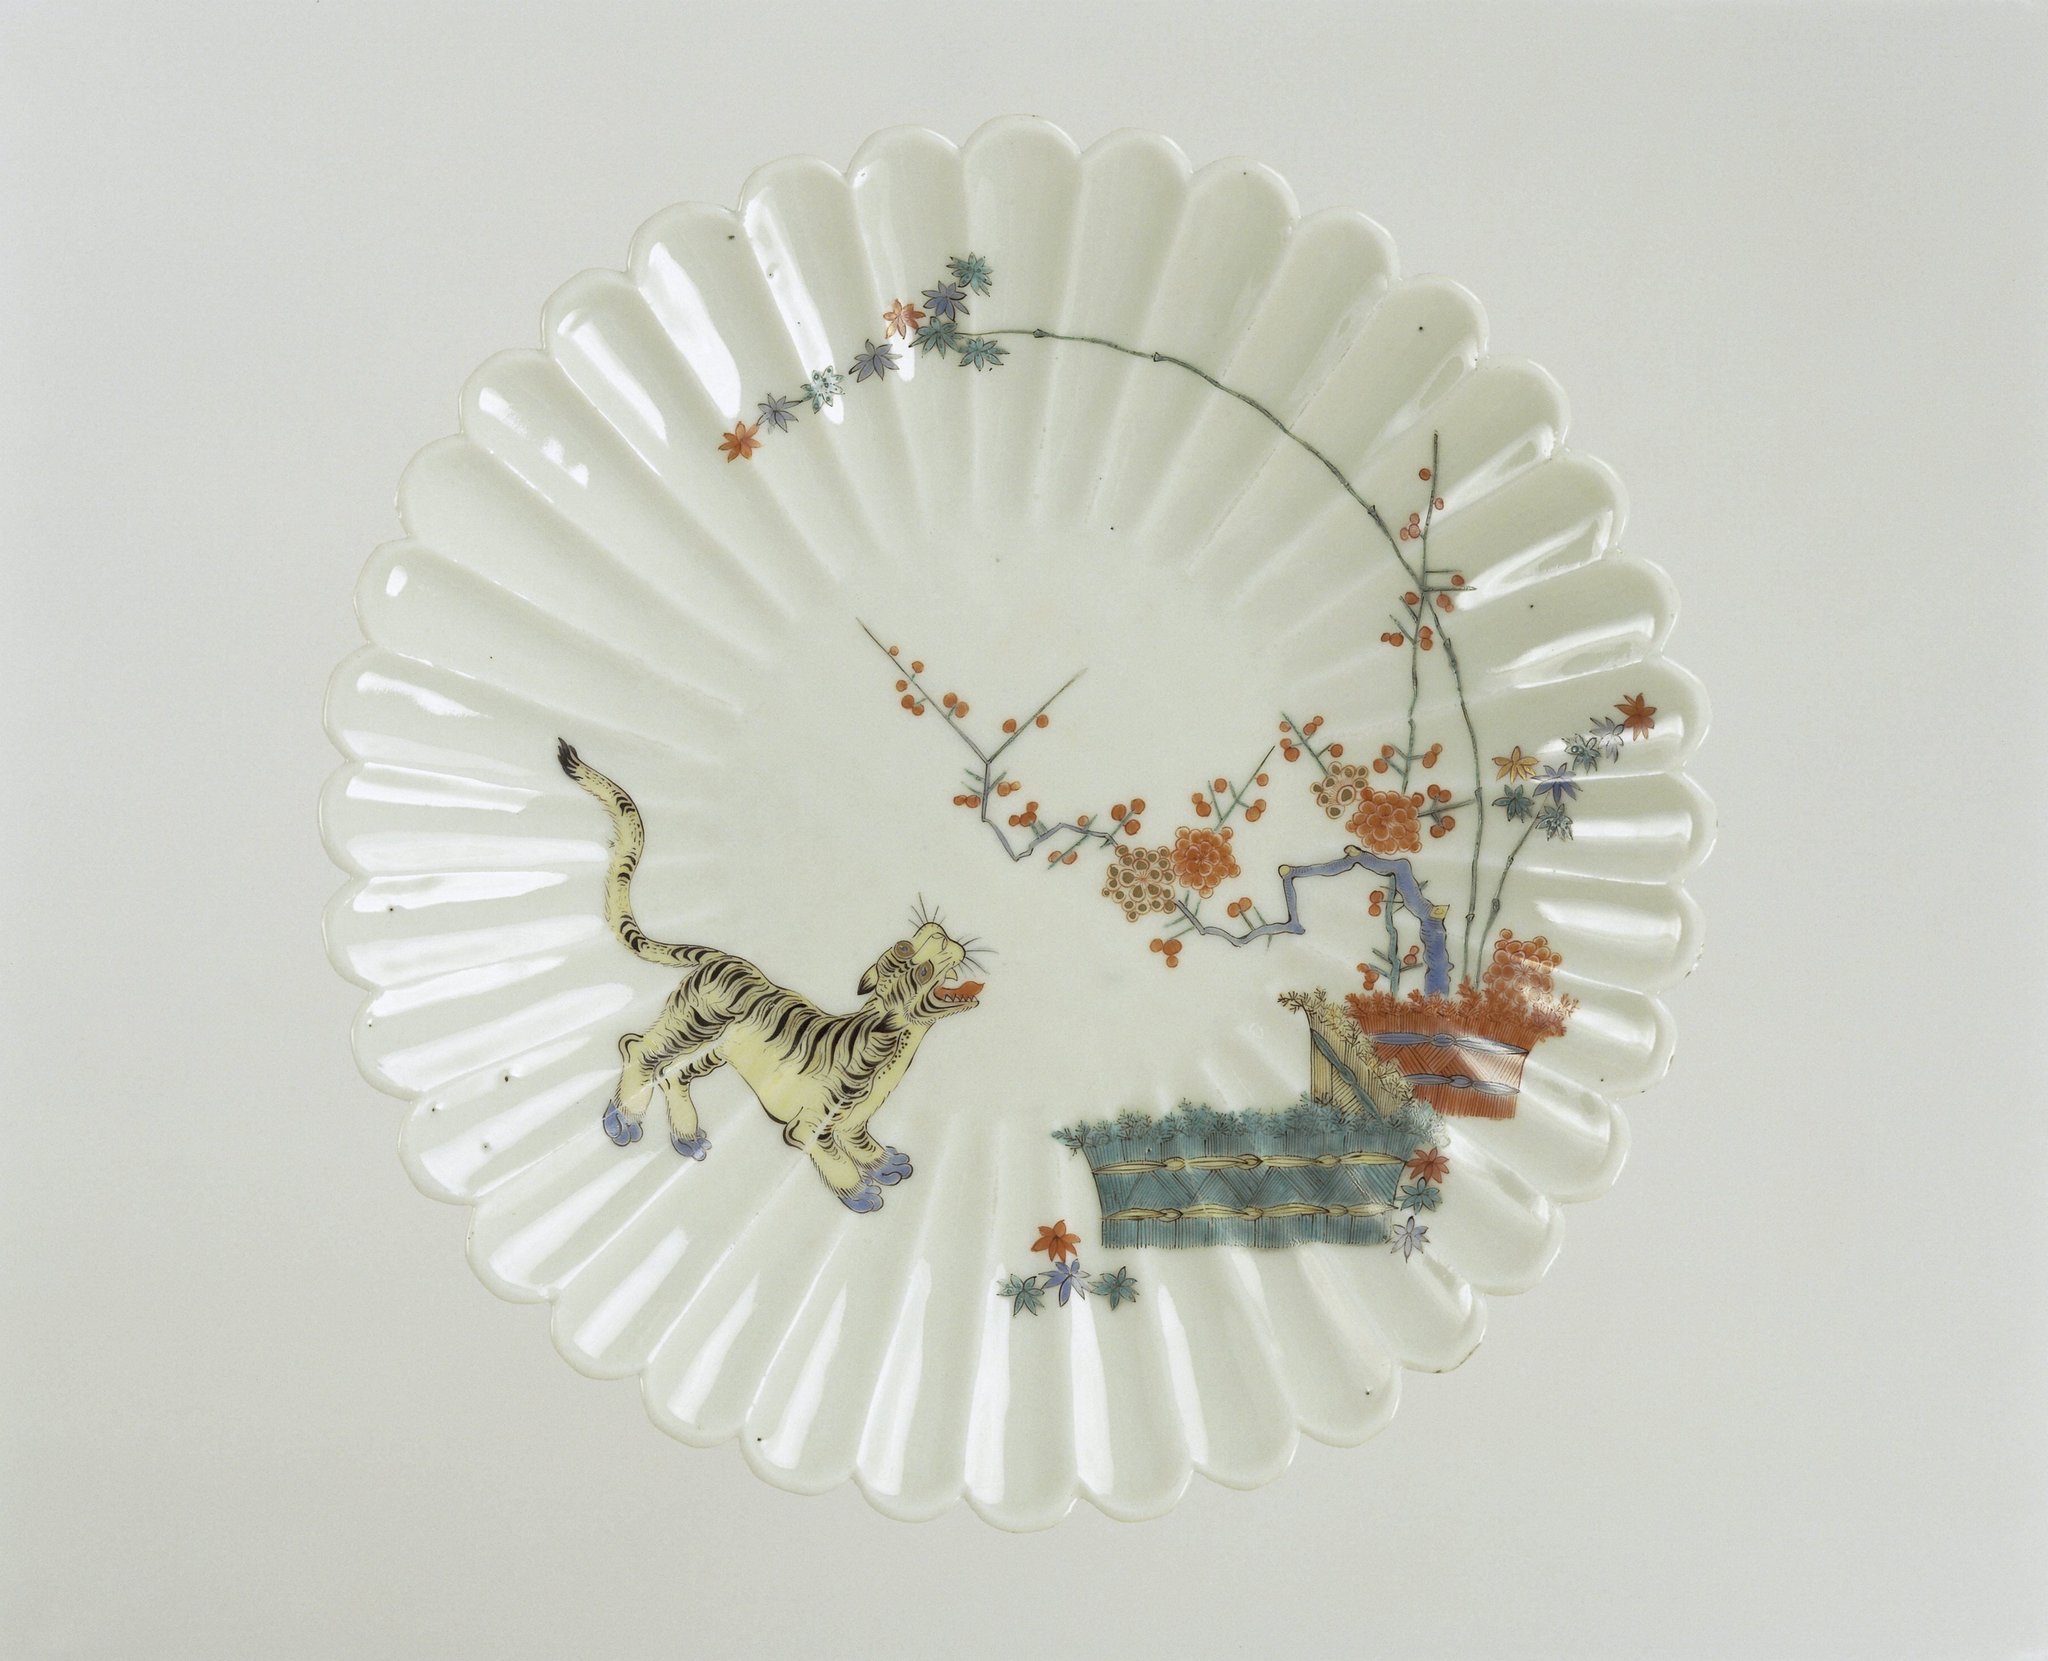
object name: eating drinking utensil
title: Schaal, veelkleurig beschilderd met een Kakiemon-decor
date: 1730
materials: porcelain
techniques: painted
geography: meissen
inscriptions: factory mark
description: Dish. Meissen c. 1725 - 1735. From the collection of August the Strong of Saxony, with the Dresden Palace inventory number N=51.